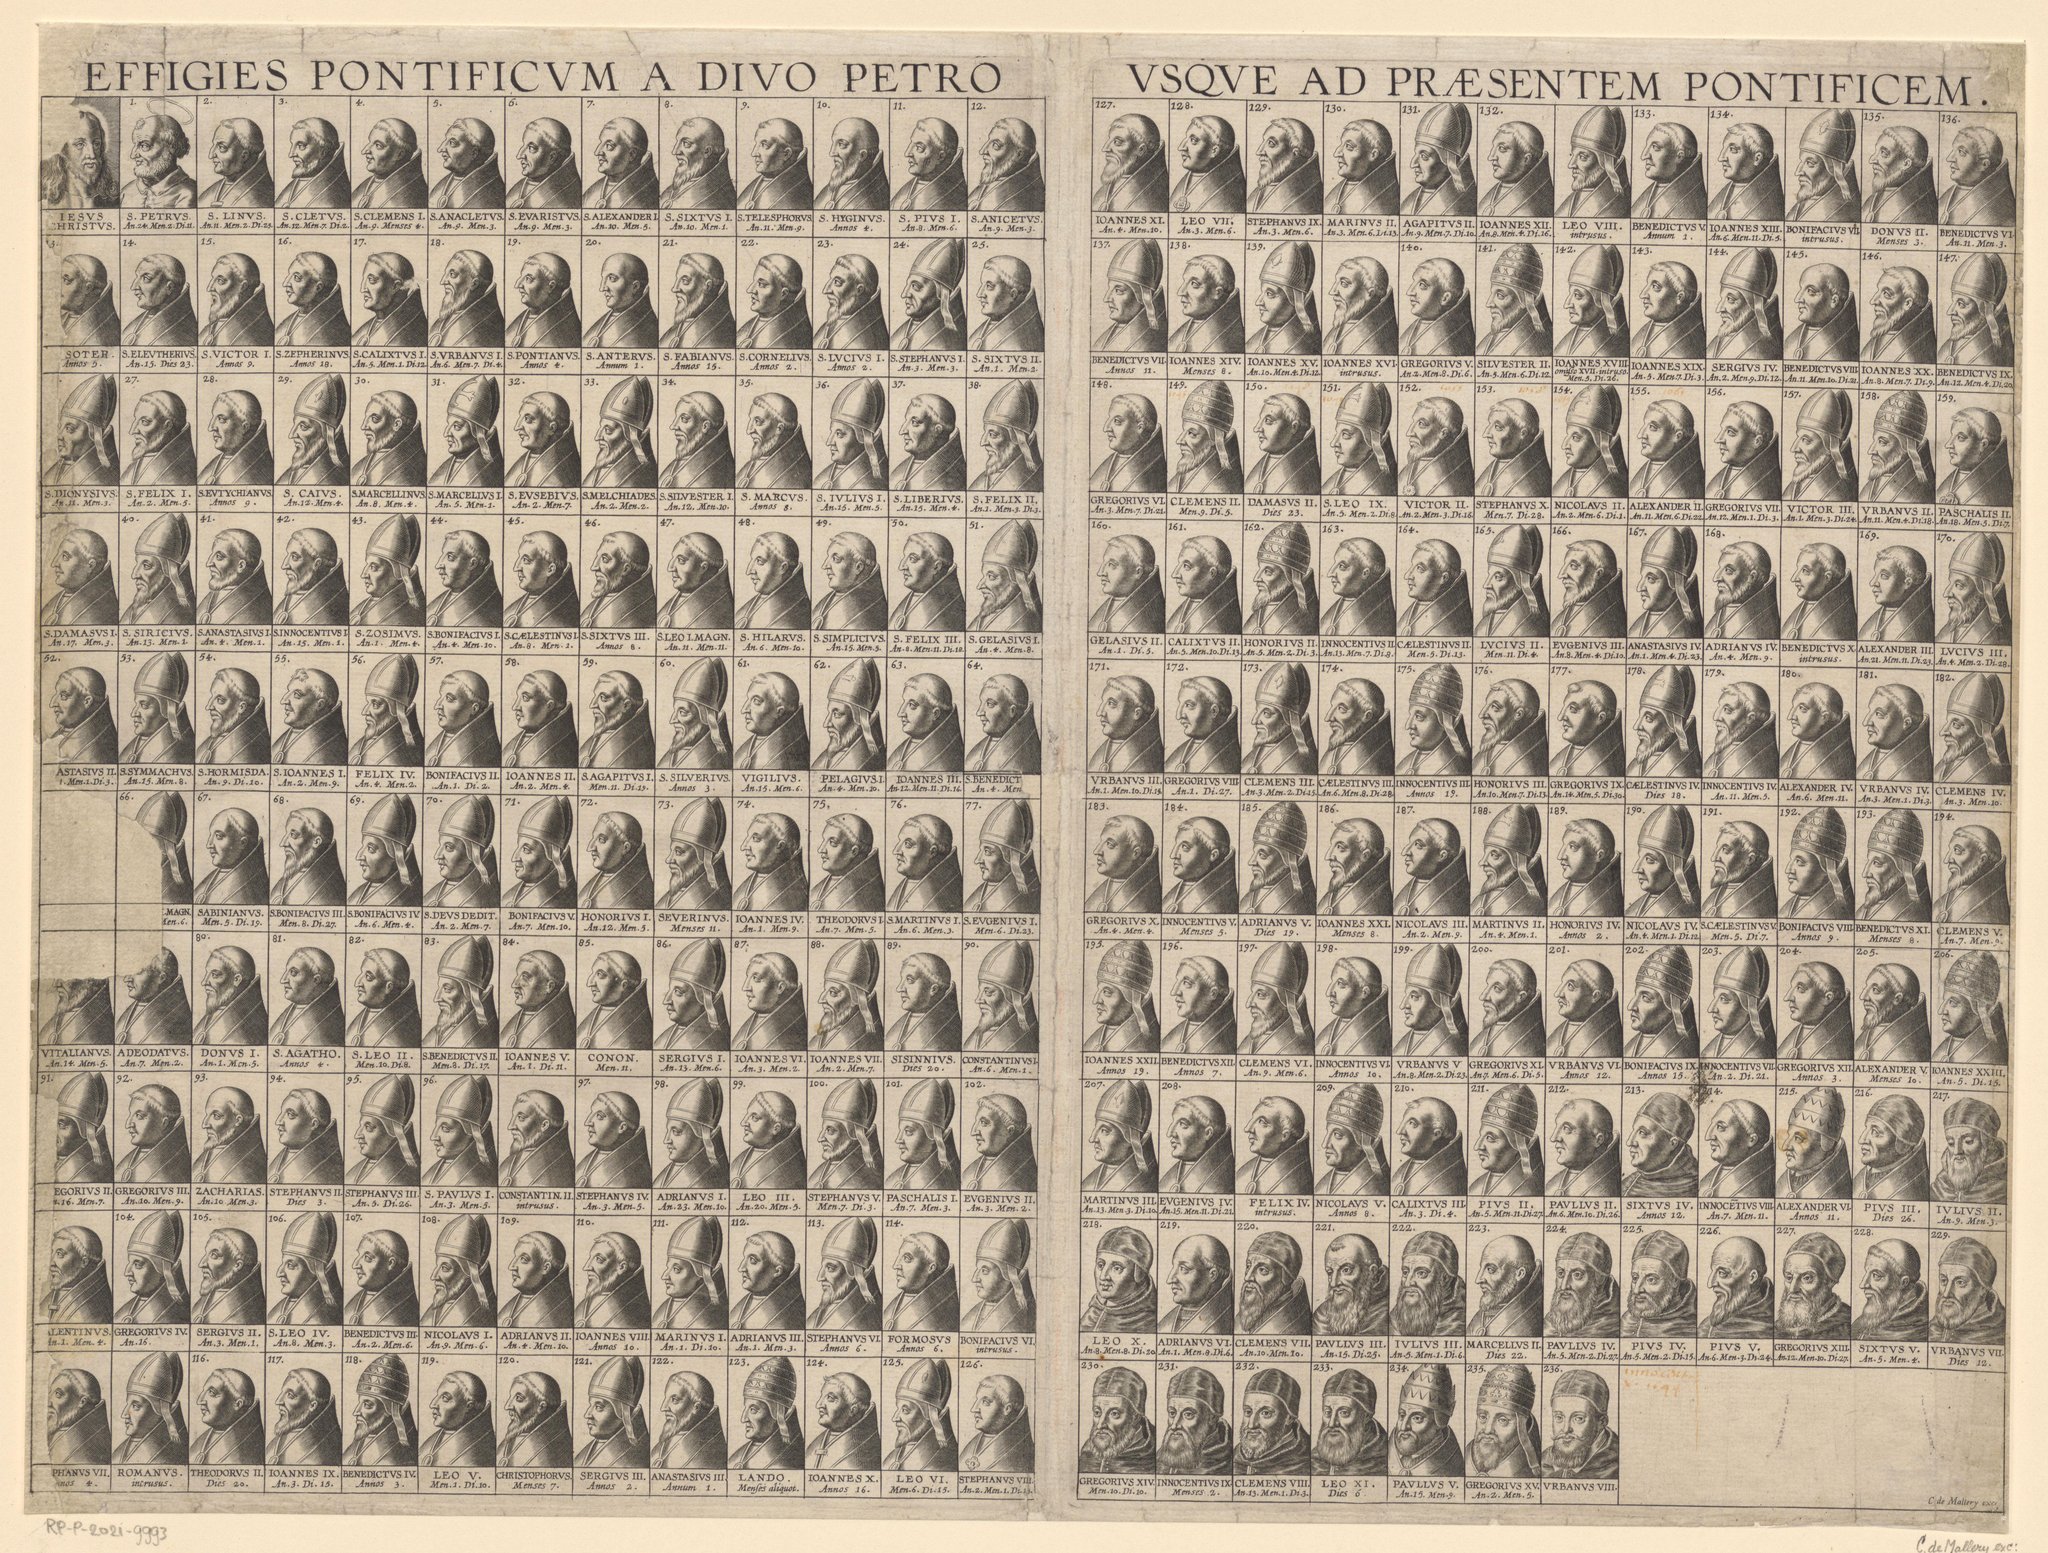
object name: print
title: Portretten van 236 pausen van Jezus en Petrus tot Urbanus VIII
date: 1623-1635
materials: paper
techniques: engraving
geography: antwerp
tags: historical persons, pope